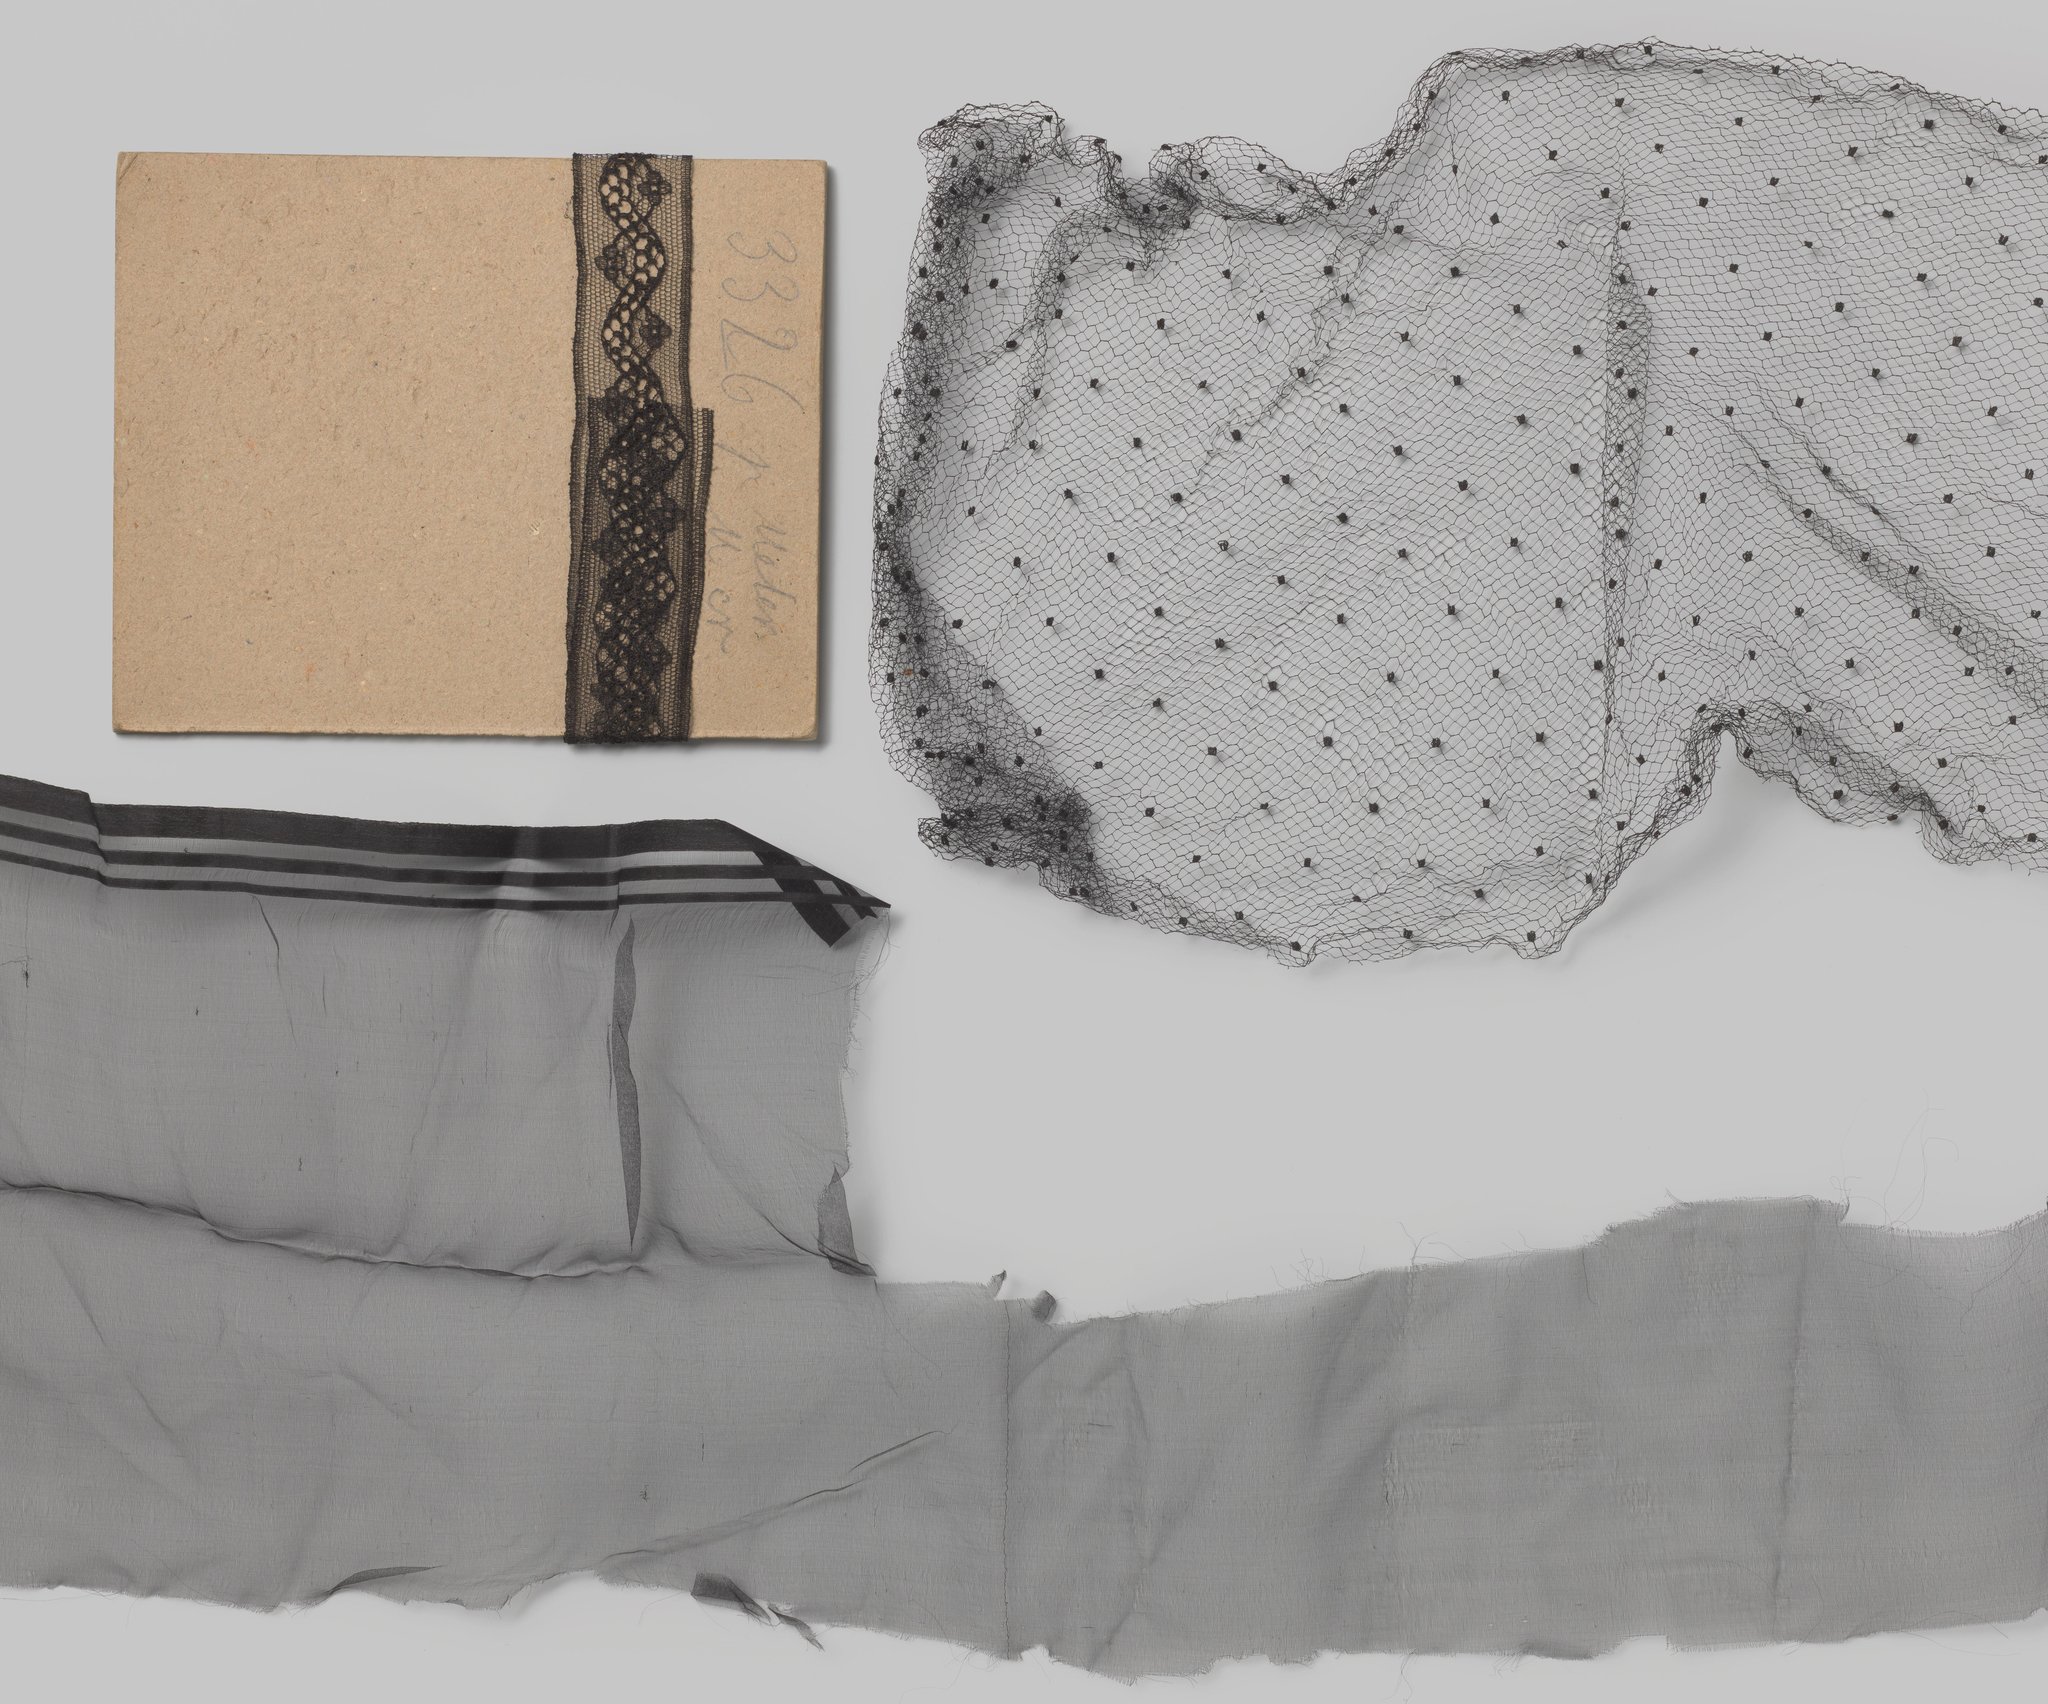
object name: veil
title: Zwarte voile van fijne tule, met kleine stippen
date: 1900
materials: silk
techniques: weave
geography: nijmegen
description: Zwarte voile van fijne tule, met kleine stippen.